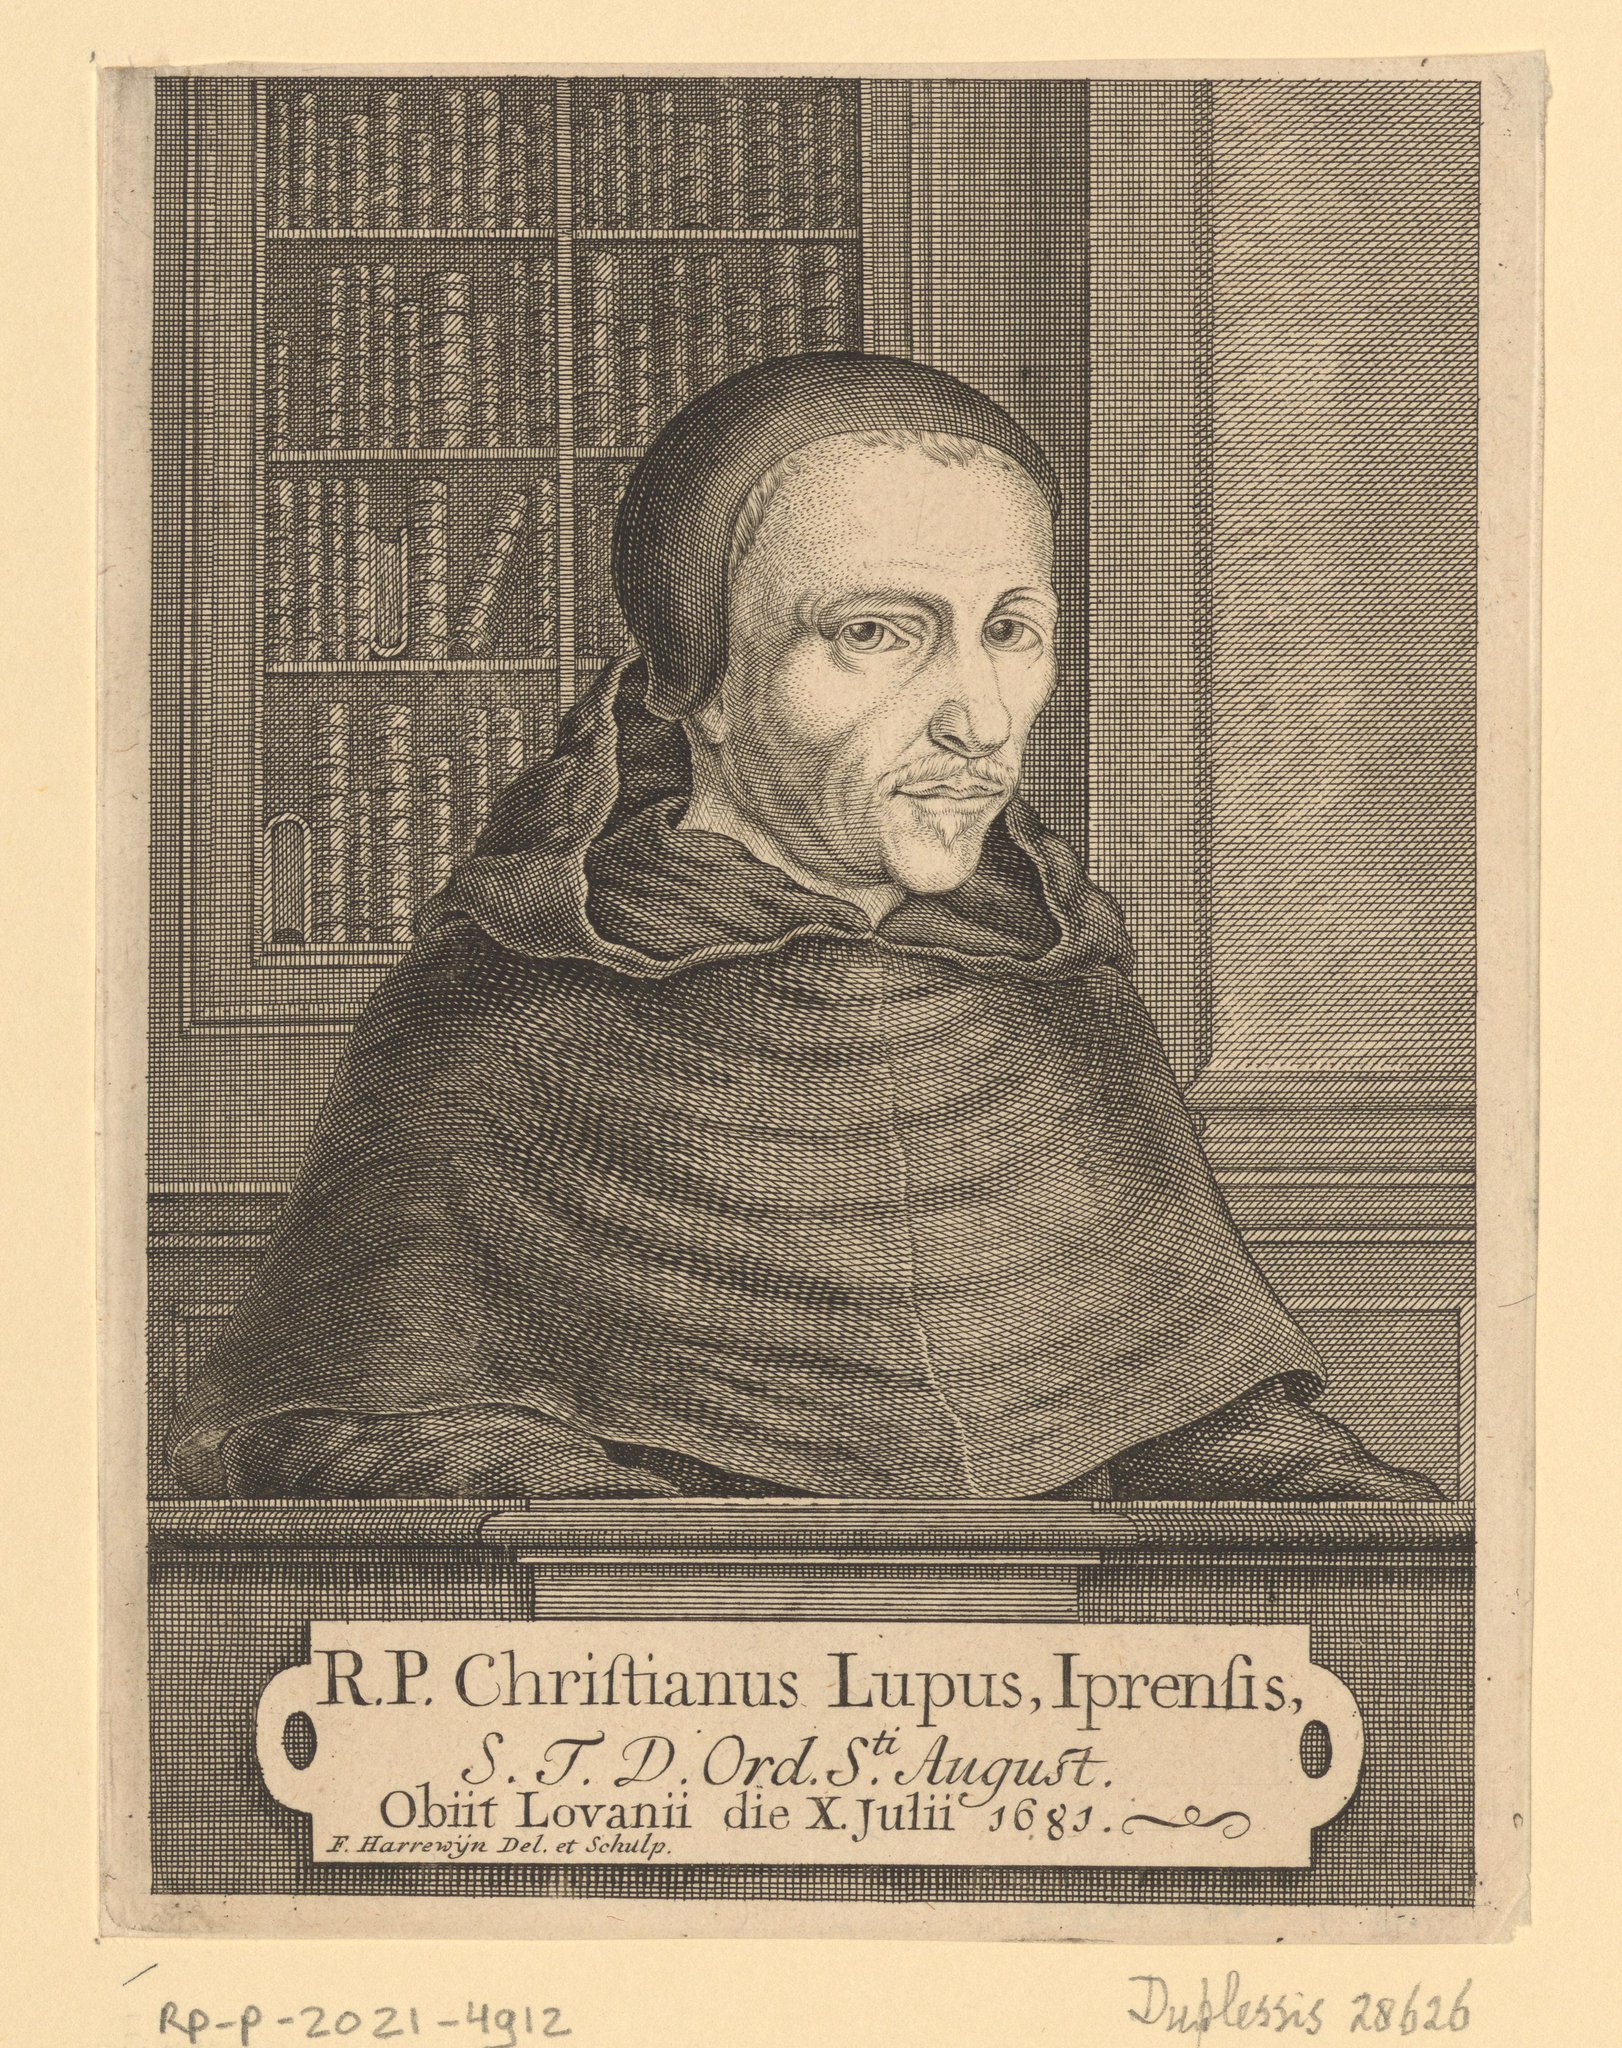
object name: book illustration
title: Portret van Christianus Lupus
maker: françois harrewijn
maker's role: print maker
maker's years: 1700-1764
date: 1739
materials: paper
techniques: engraving, etching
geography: brussels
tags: bookshelves, theologian, historical persons, monk(s), friar(s)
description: Prent waarschijnlijk uit: Foppens, J.F. Bibliotheca Belgica (...). Brussel: Petrus Foppens, 1739.